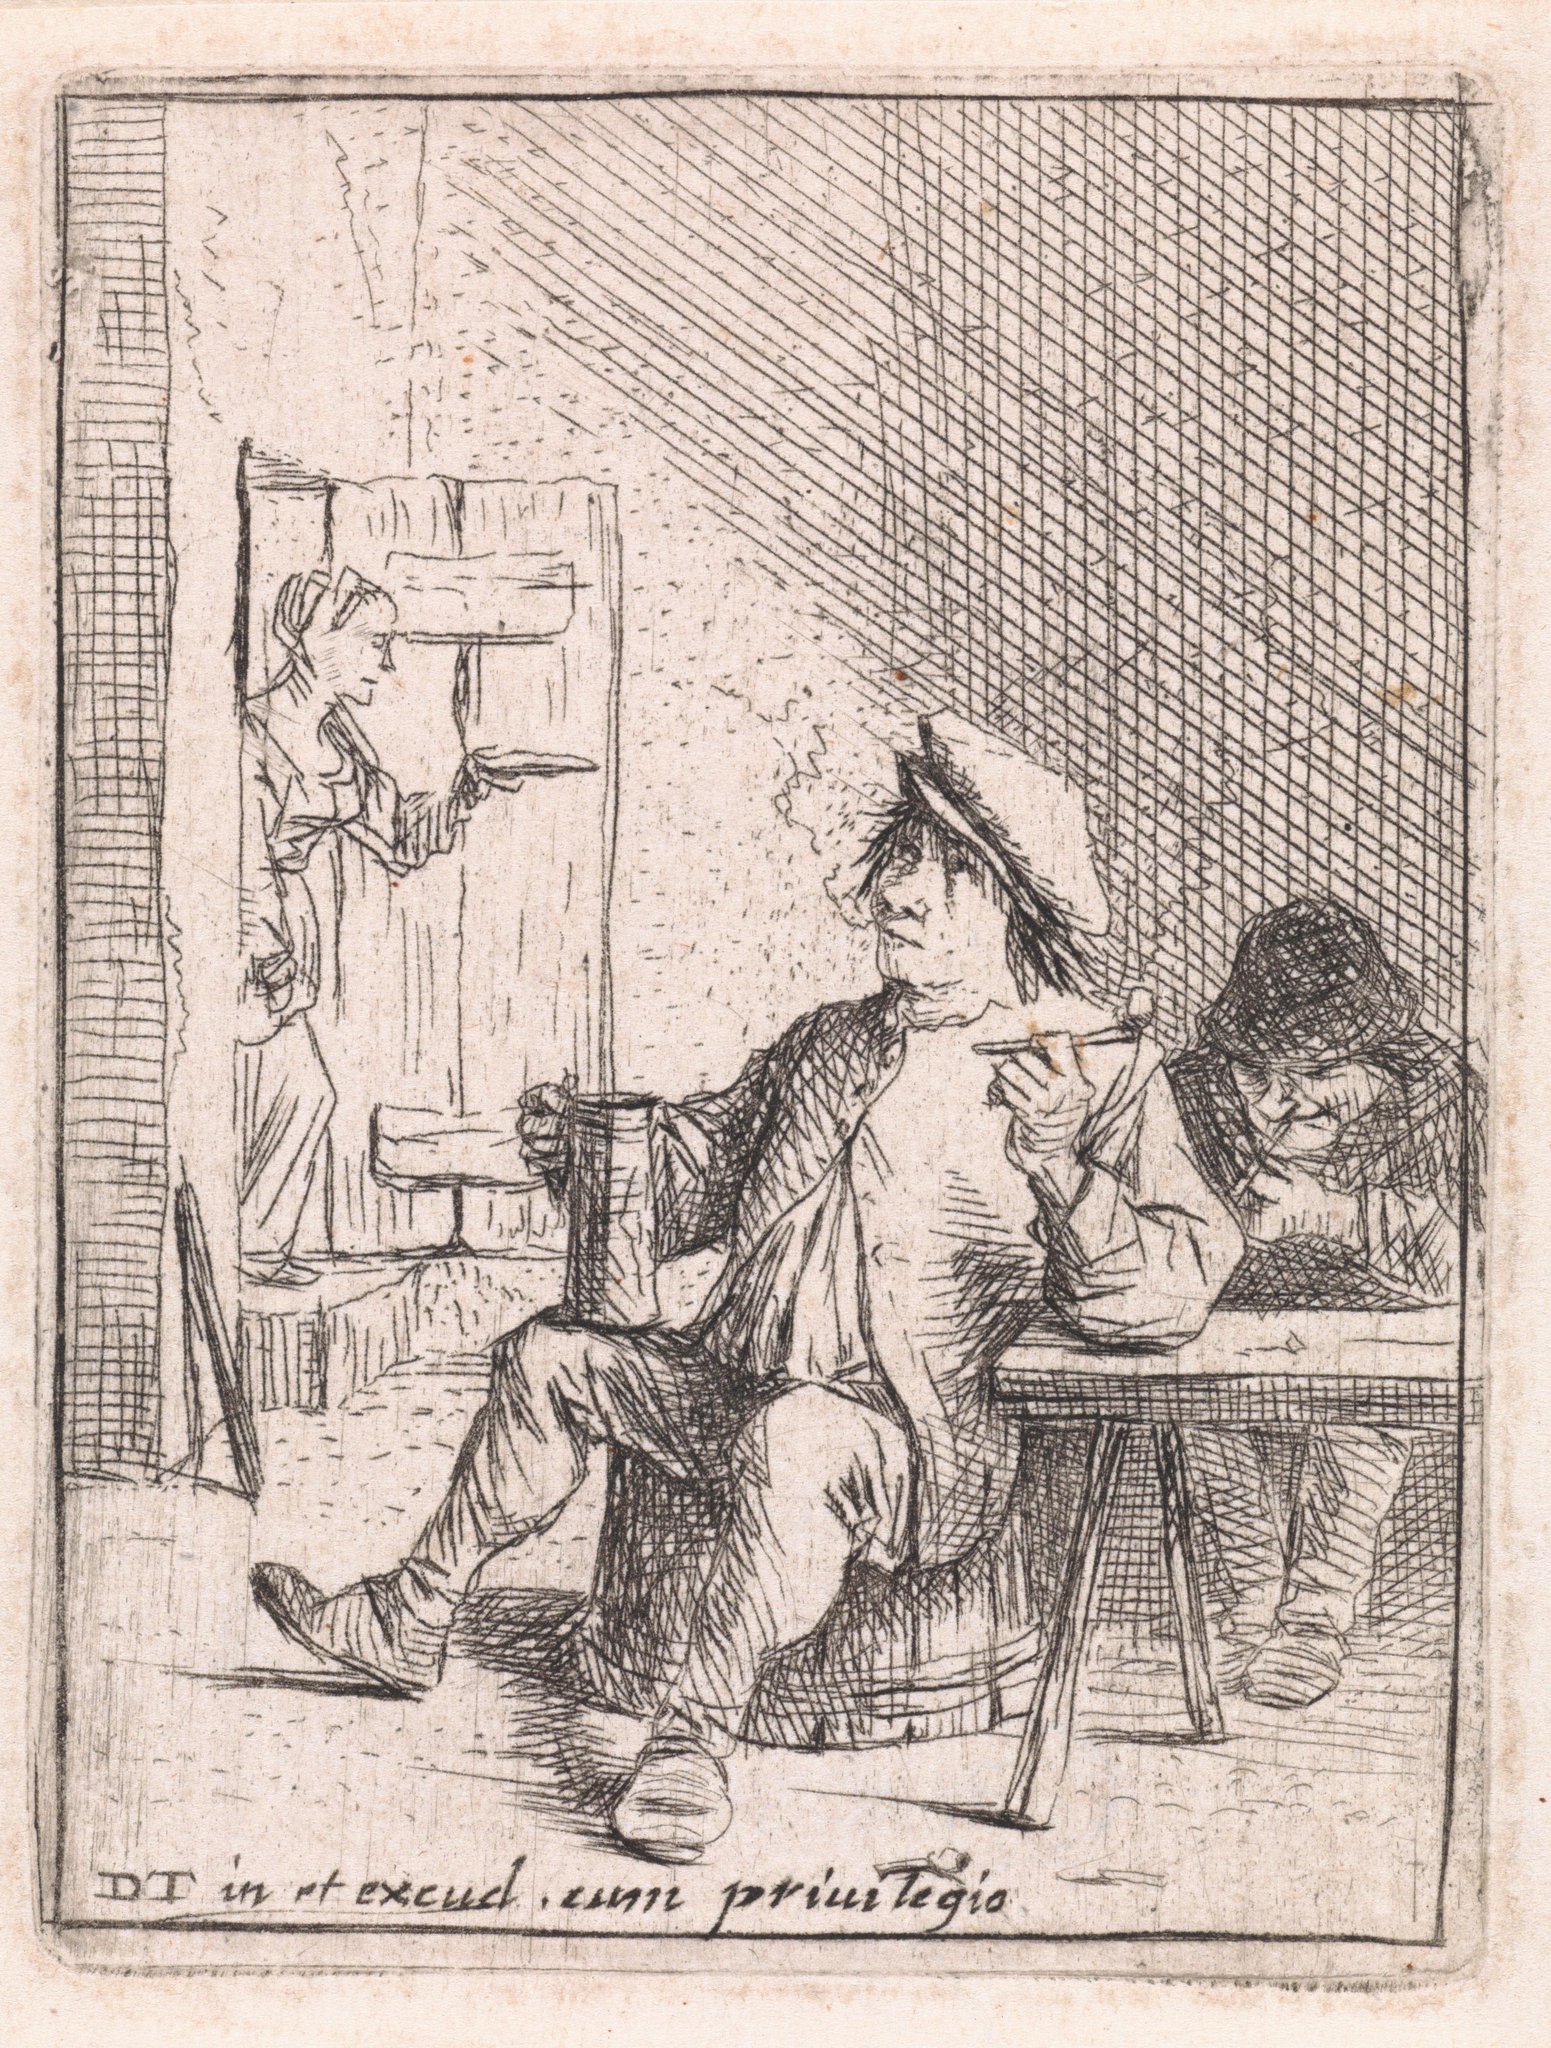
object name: print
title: Zittende boer met kruik en pijp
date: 1626-1690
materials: paper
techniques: etching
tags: pipe ~ tobacco, opening the door, drinking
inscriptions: collector's mark: Lugt 2228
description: Een boer zit links naast een tafel, met een kruik en een pijp in zijn handen. Achter de tafel zit een man. Links komt een vrouw door de deur de ruimte binnen.